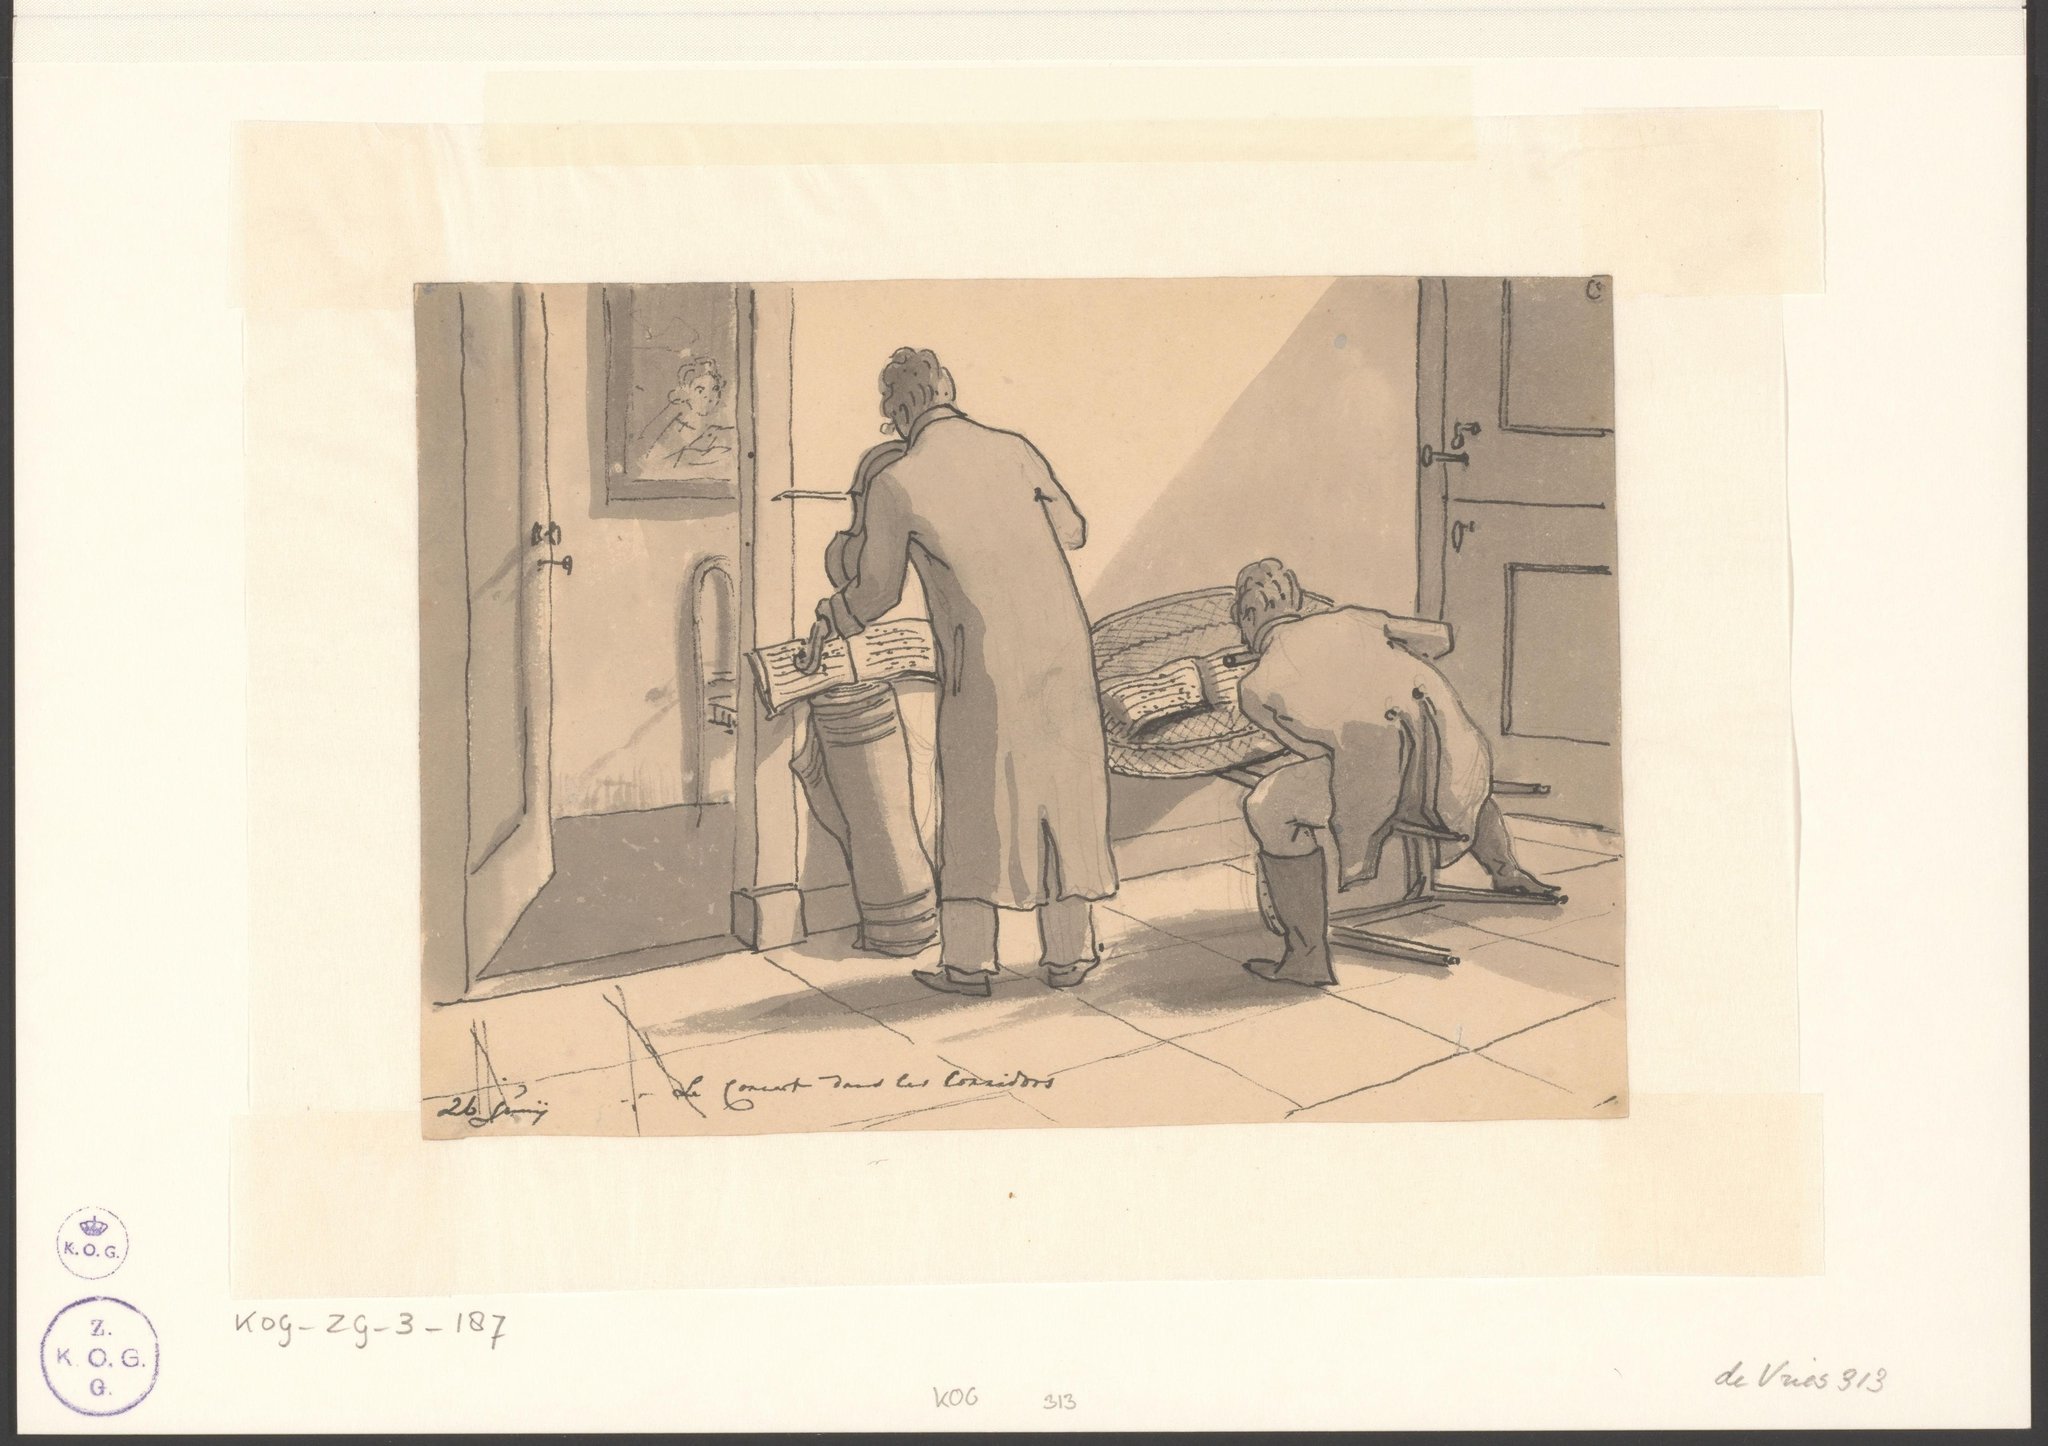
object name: drawing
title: Christiaan Andriessen speelt geïmproviseerd concert voor viool en fluit in de gang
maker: christiaan andriessen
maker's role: draughtsman, print maker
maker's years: 1775-1846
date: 1805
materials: ink, paper, pencil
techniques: brush, pen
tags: amsterdam, print maker, draughtsman, christiaan andriessen, violin, fiddle, flute, aulos, tibia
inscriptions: signature: ‘J Andriessen’, collector's mark: Lugt 1641, collector's mark: Lugt 1641a, inscription: ‘26 junij Le concert dans les corridors’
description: Dagboekblad uit het getekende dagboek dat Christiaan Andriessen bijhield van 1805 tot en met 1808.